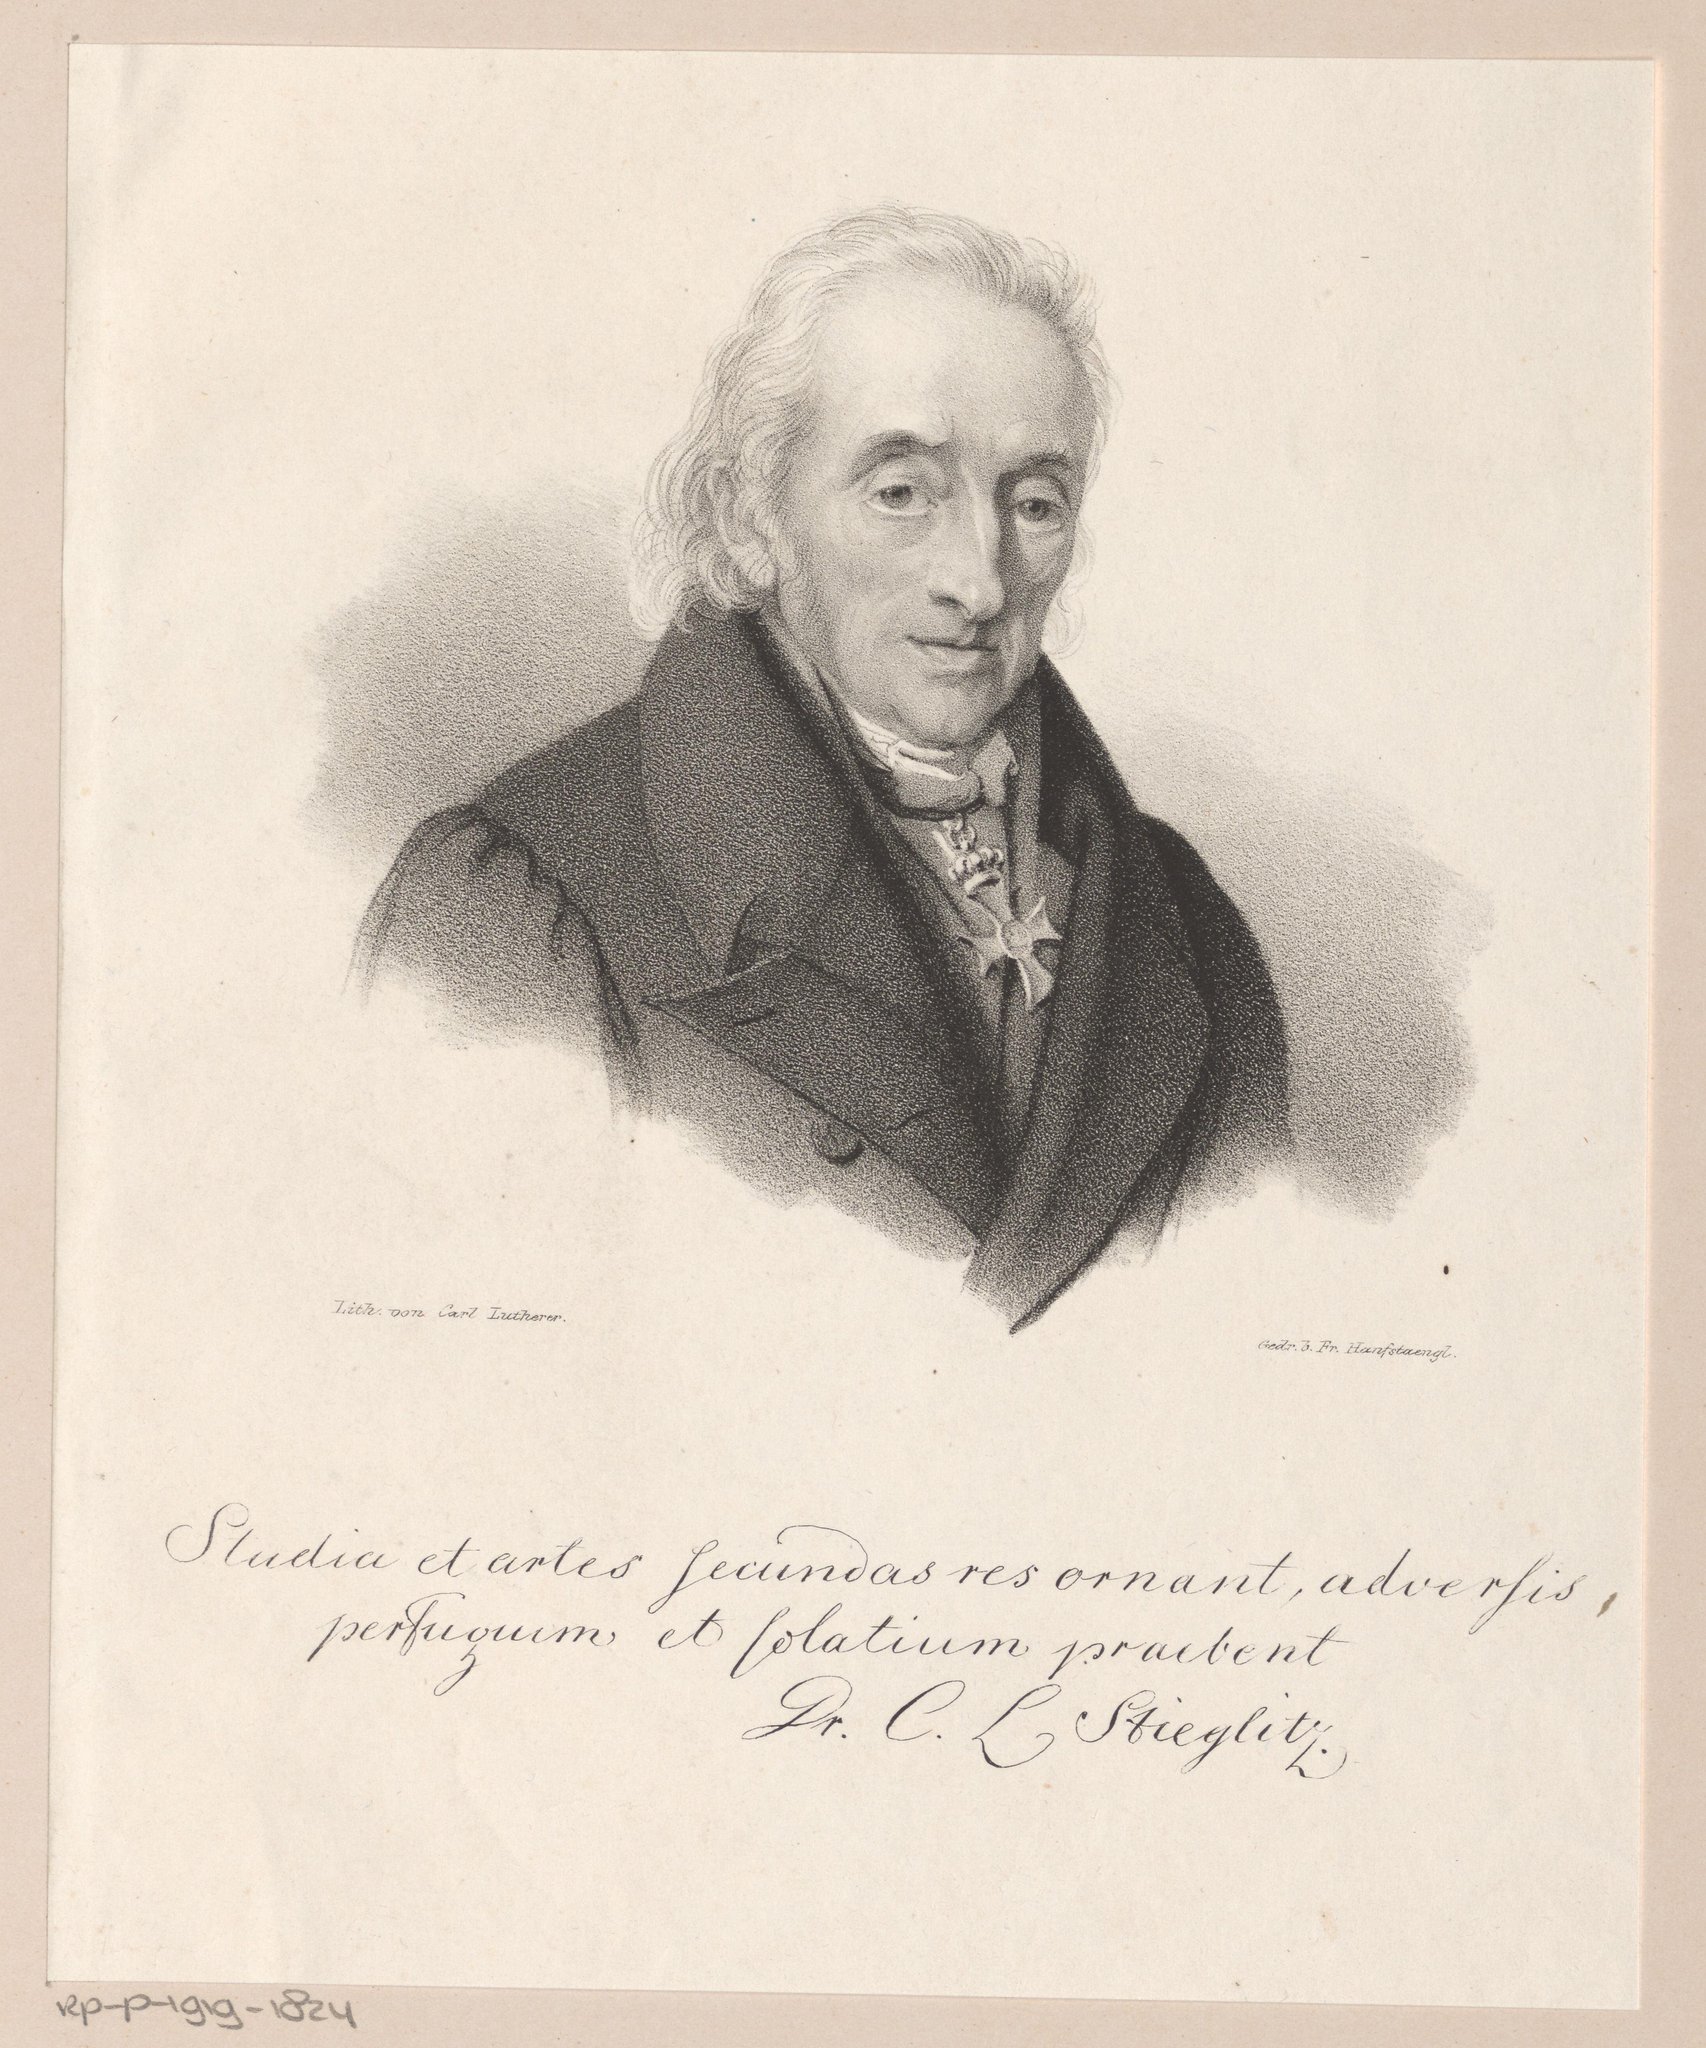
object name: print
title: Portret van Christian Ludwig Stieglitz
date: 1817-1850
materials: paper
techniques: lithograph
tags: historical persons, magistracy, judges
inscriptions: collector's mark: Lugt 2228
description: Met tweeregelig handgeschreven onderschrift in het Latijn.